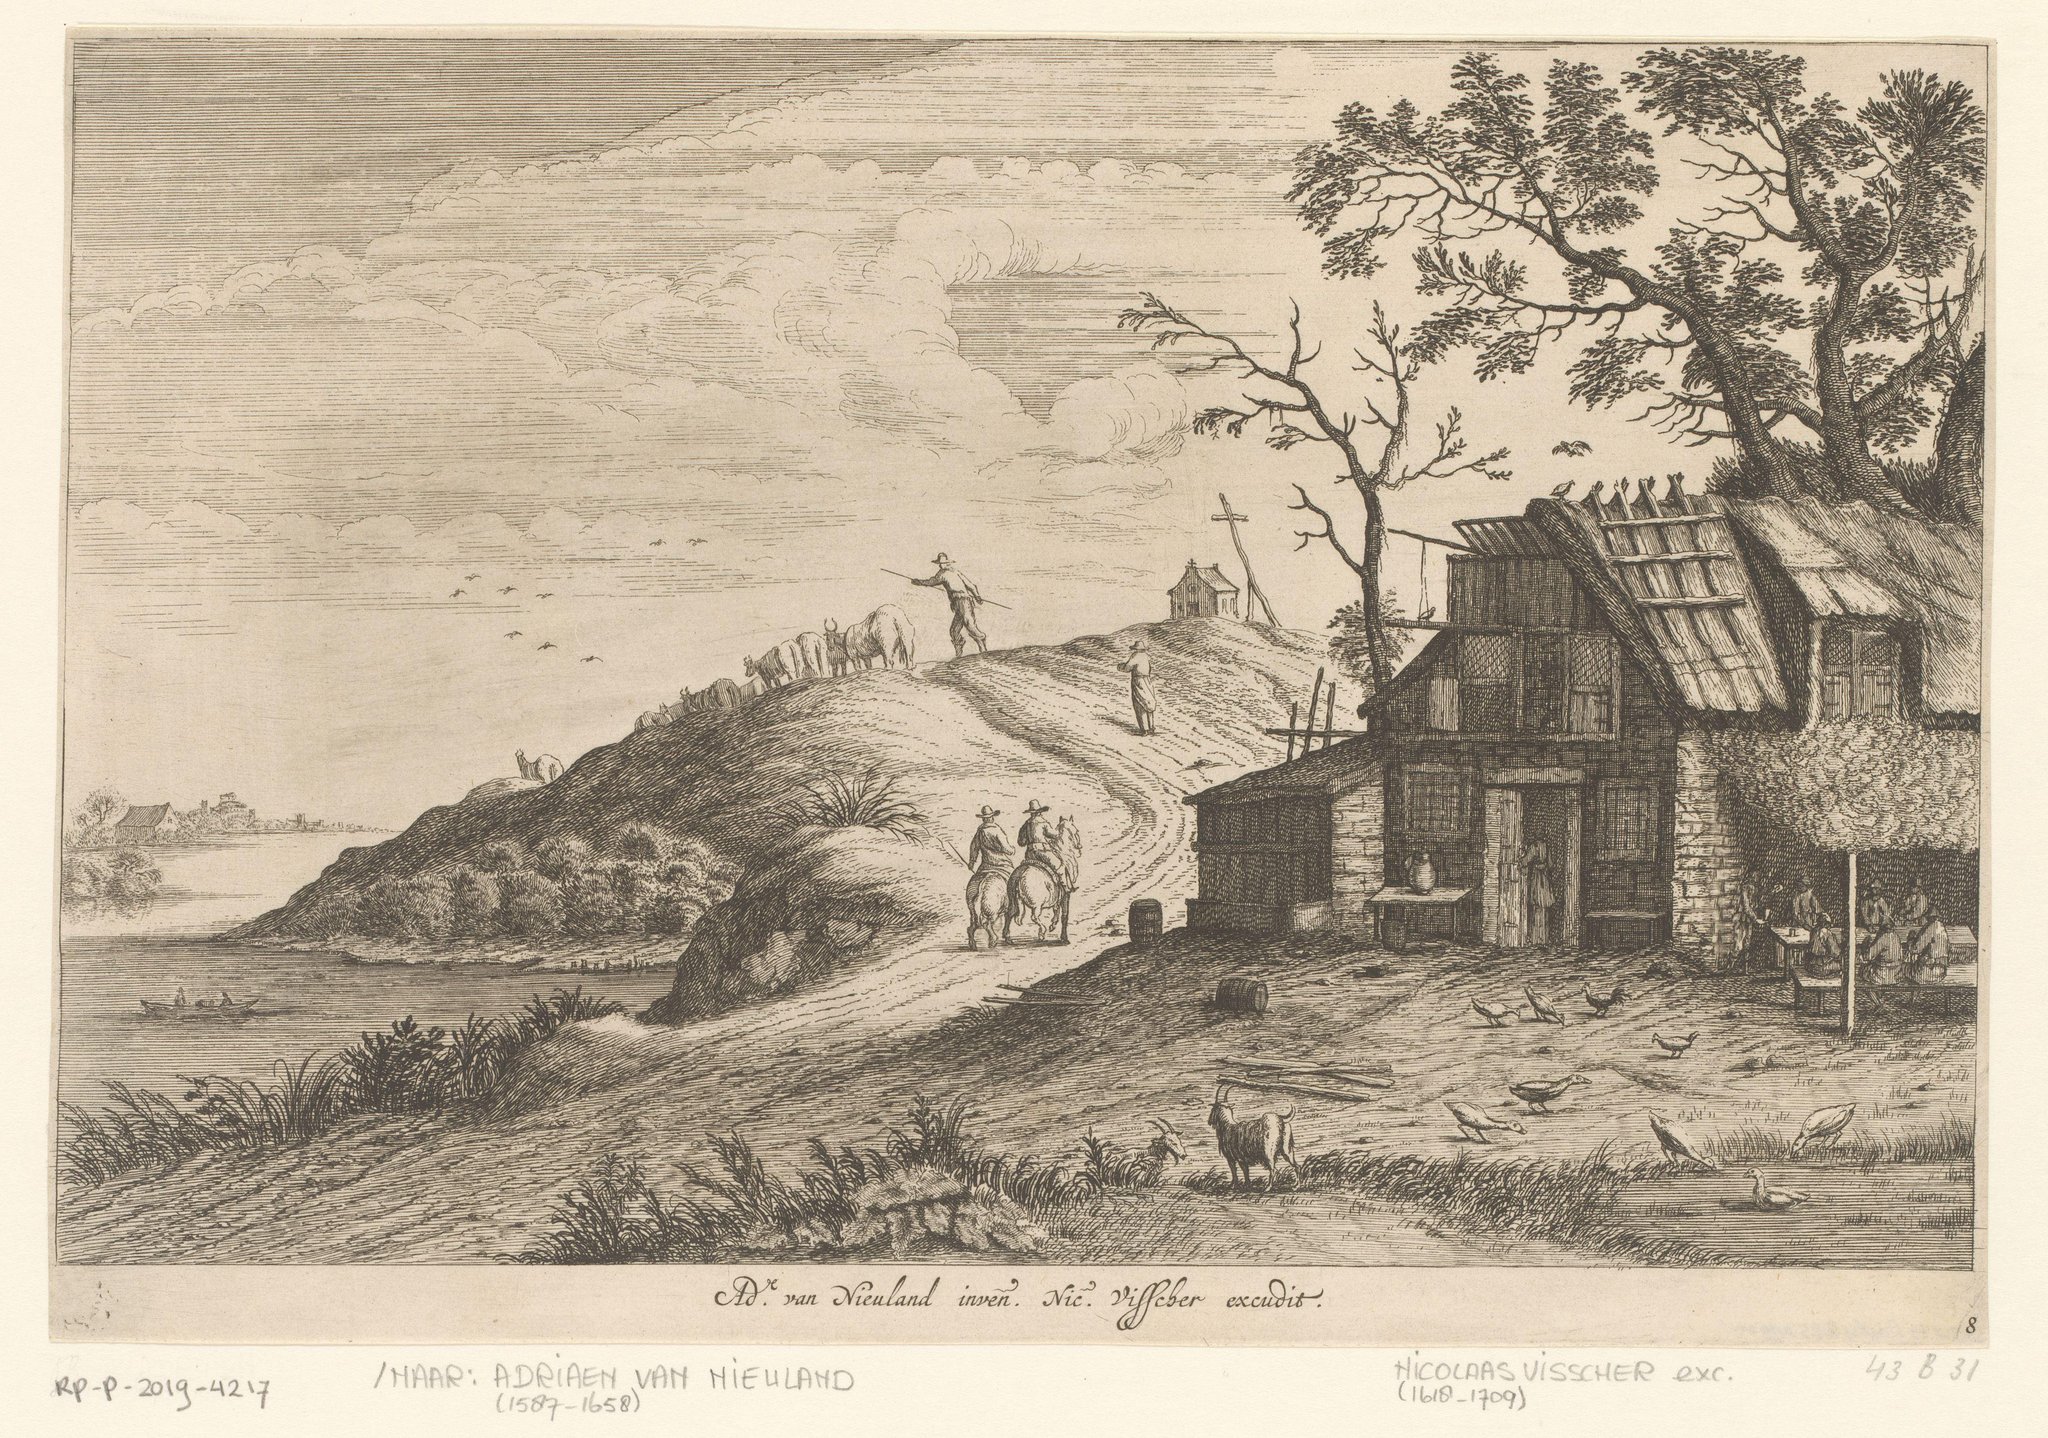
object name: print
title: Landschappen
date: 1623-1652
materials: paper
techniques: etching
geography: amsterdam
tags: inn, coffee-house, public house, etc., water course, road, path, cattle driving, cattle driver, church (exterior) - qq - small church, chapel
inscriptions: collector's mark: Lugt 2228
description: Uitspanning met overkapping, waaronder een gezelschap aan tafel. Op de weg twee ruiters en een veedrijver met zijn vee. Op de heuvel staat een kapel, op het water vaart een boot. Prent uit een serie landschappen.